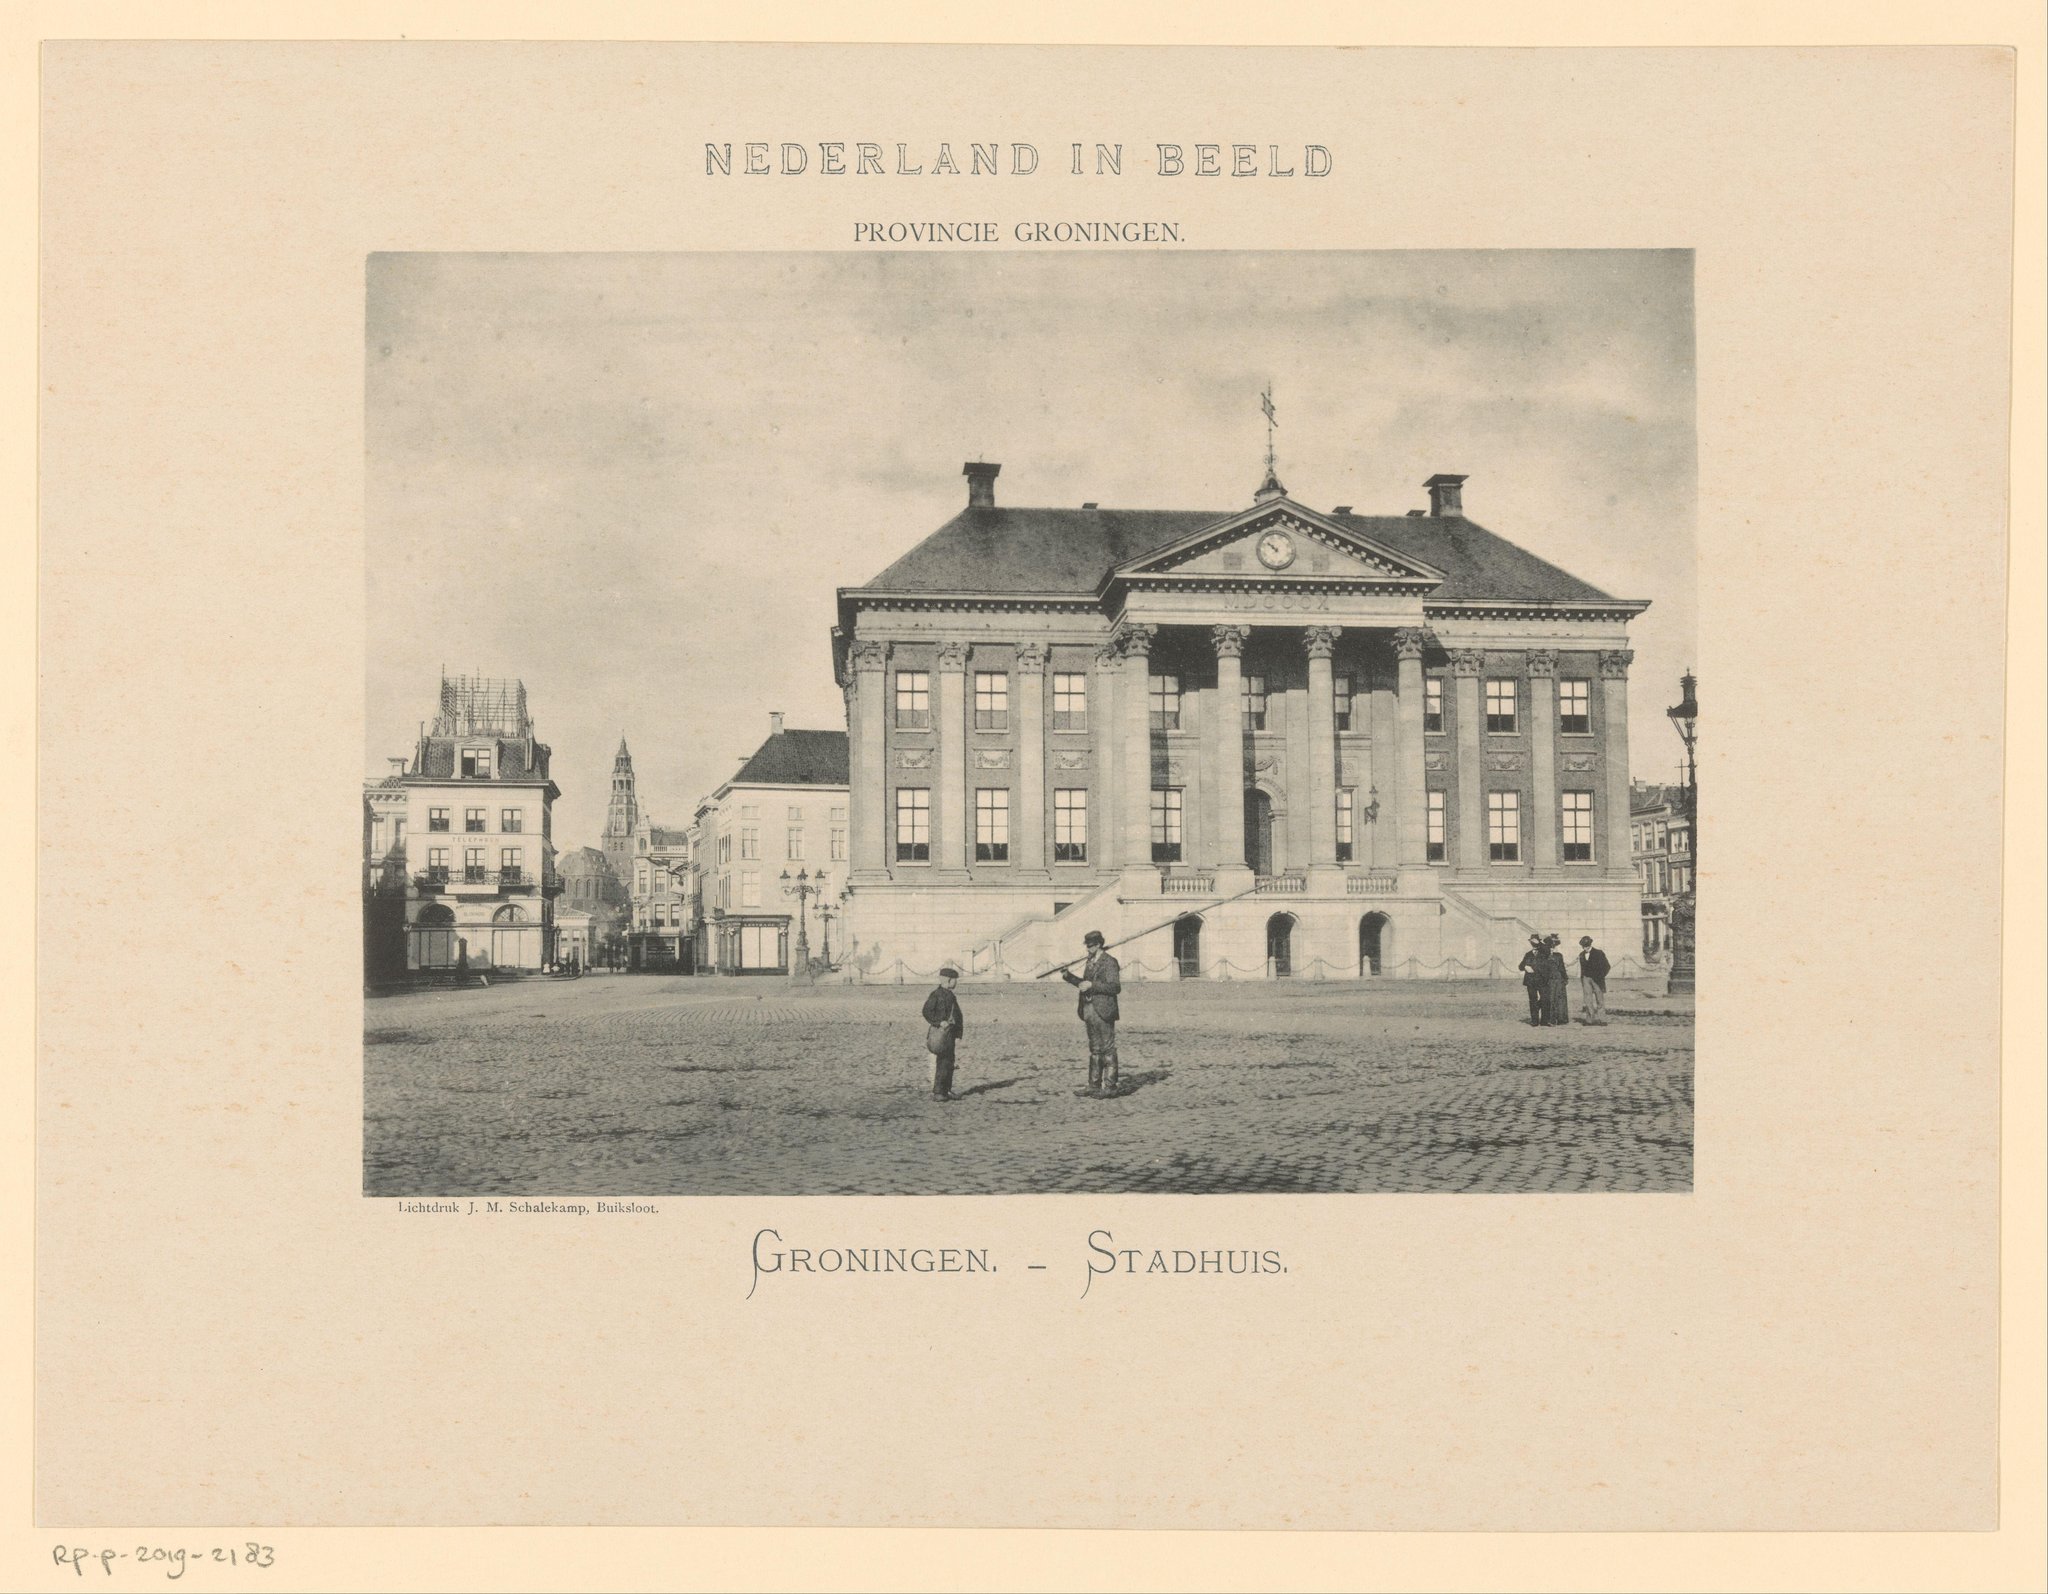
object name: photomechanical print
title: Groningen - Stadhuis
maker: johan marinus schalekamp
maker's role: publisher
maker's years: 1844-1912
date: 1896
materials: paper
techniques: photograph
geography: buiksloot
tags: townhall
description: Afdruk uit: Nederland in Beeld. Buiksloot: J.M. Schalekamp, 1896.